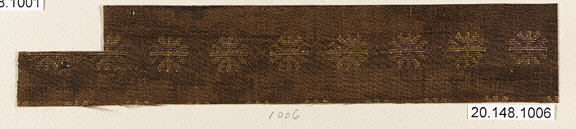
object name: piece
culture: japanese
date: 1801-1900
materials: silk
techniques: compound weave